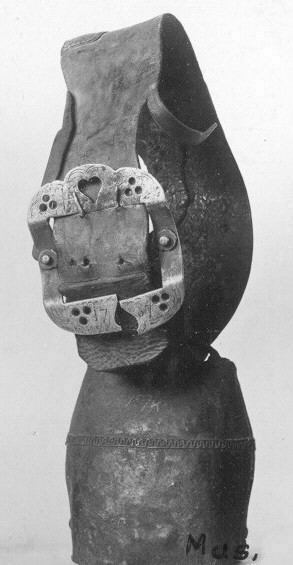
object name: cattle bell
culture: swiss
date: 1707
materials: metal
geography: switzerland